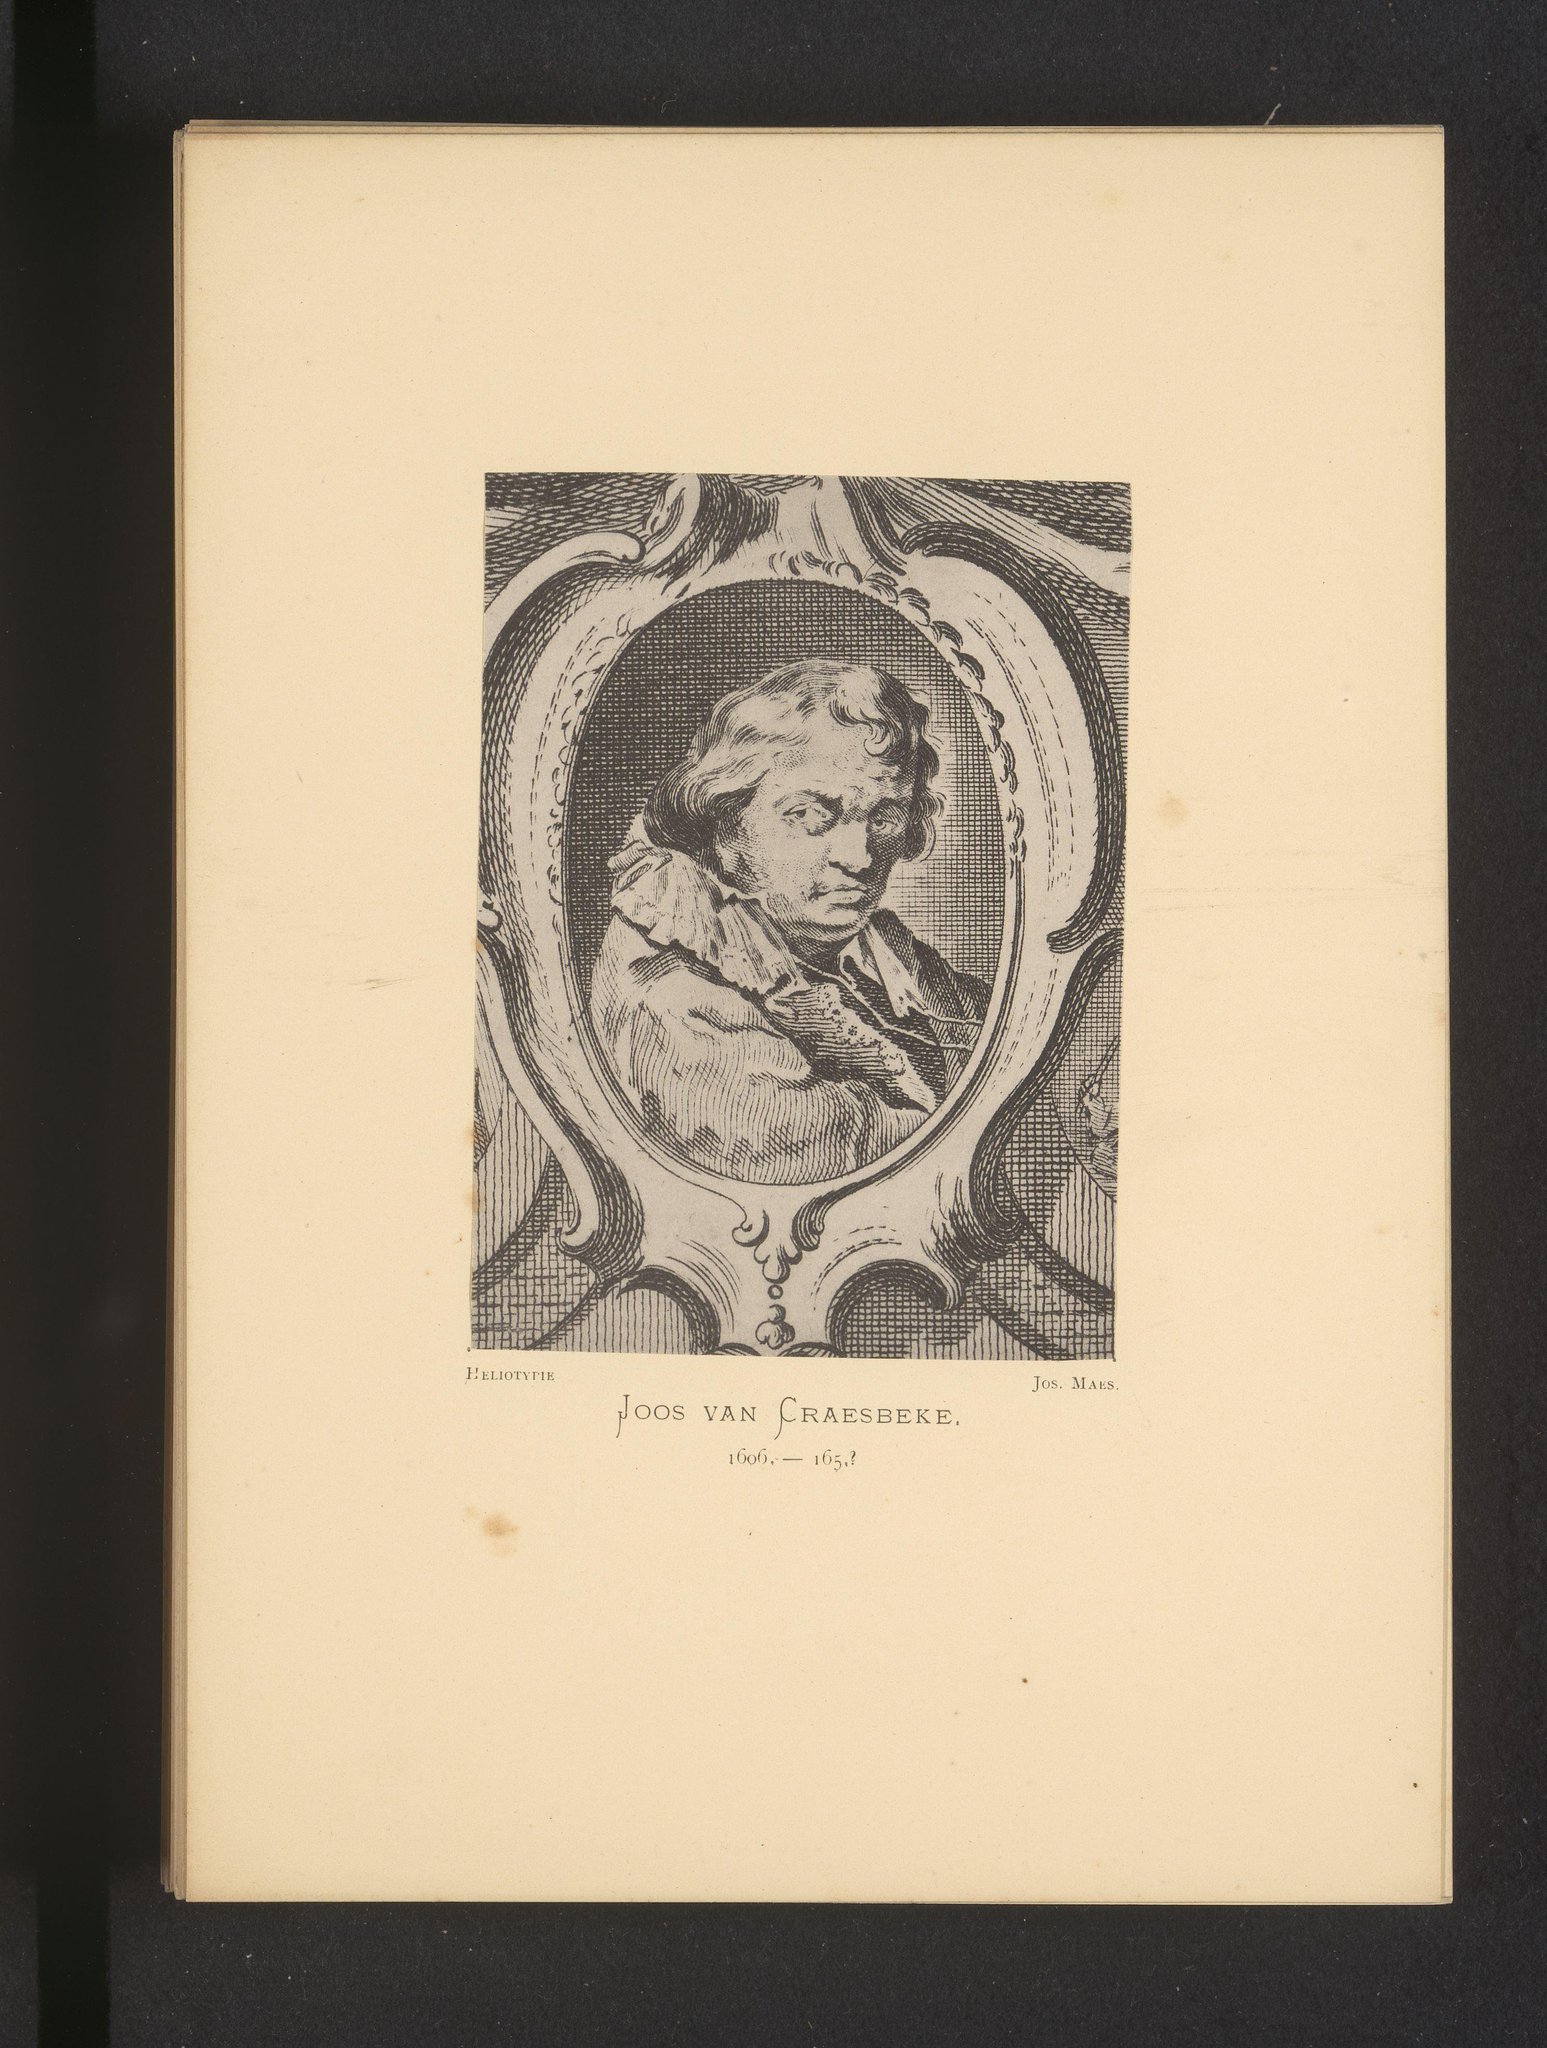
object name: reproduction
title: Reproductie van een gravure van een portret van Joos van Craesbeeck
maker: joseph maes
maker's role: fotograaf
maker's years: 1838-1908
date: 1872-1877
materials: cardboard, paper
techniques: photograph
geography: antwerp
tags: brussels, draughtsman, joos van craesbeeck, historical persons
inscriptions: inscription: ‘1606. - 165.?’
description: Deze prent maakt deel uit van een omslag met 150 prenten en een katern met een lijst van afbeeldingen.